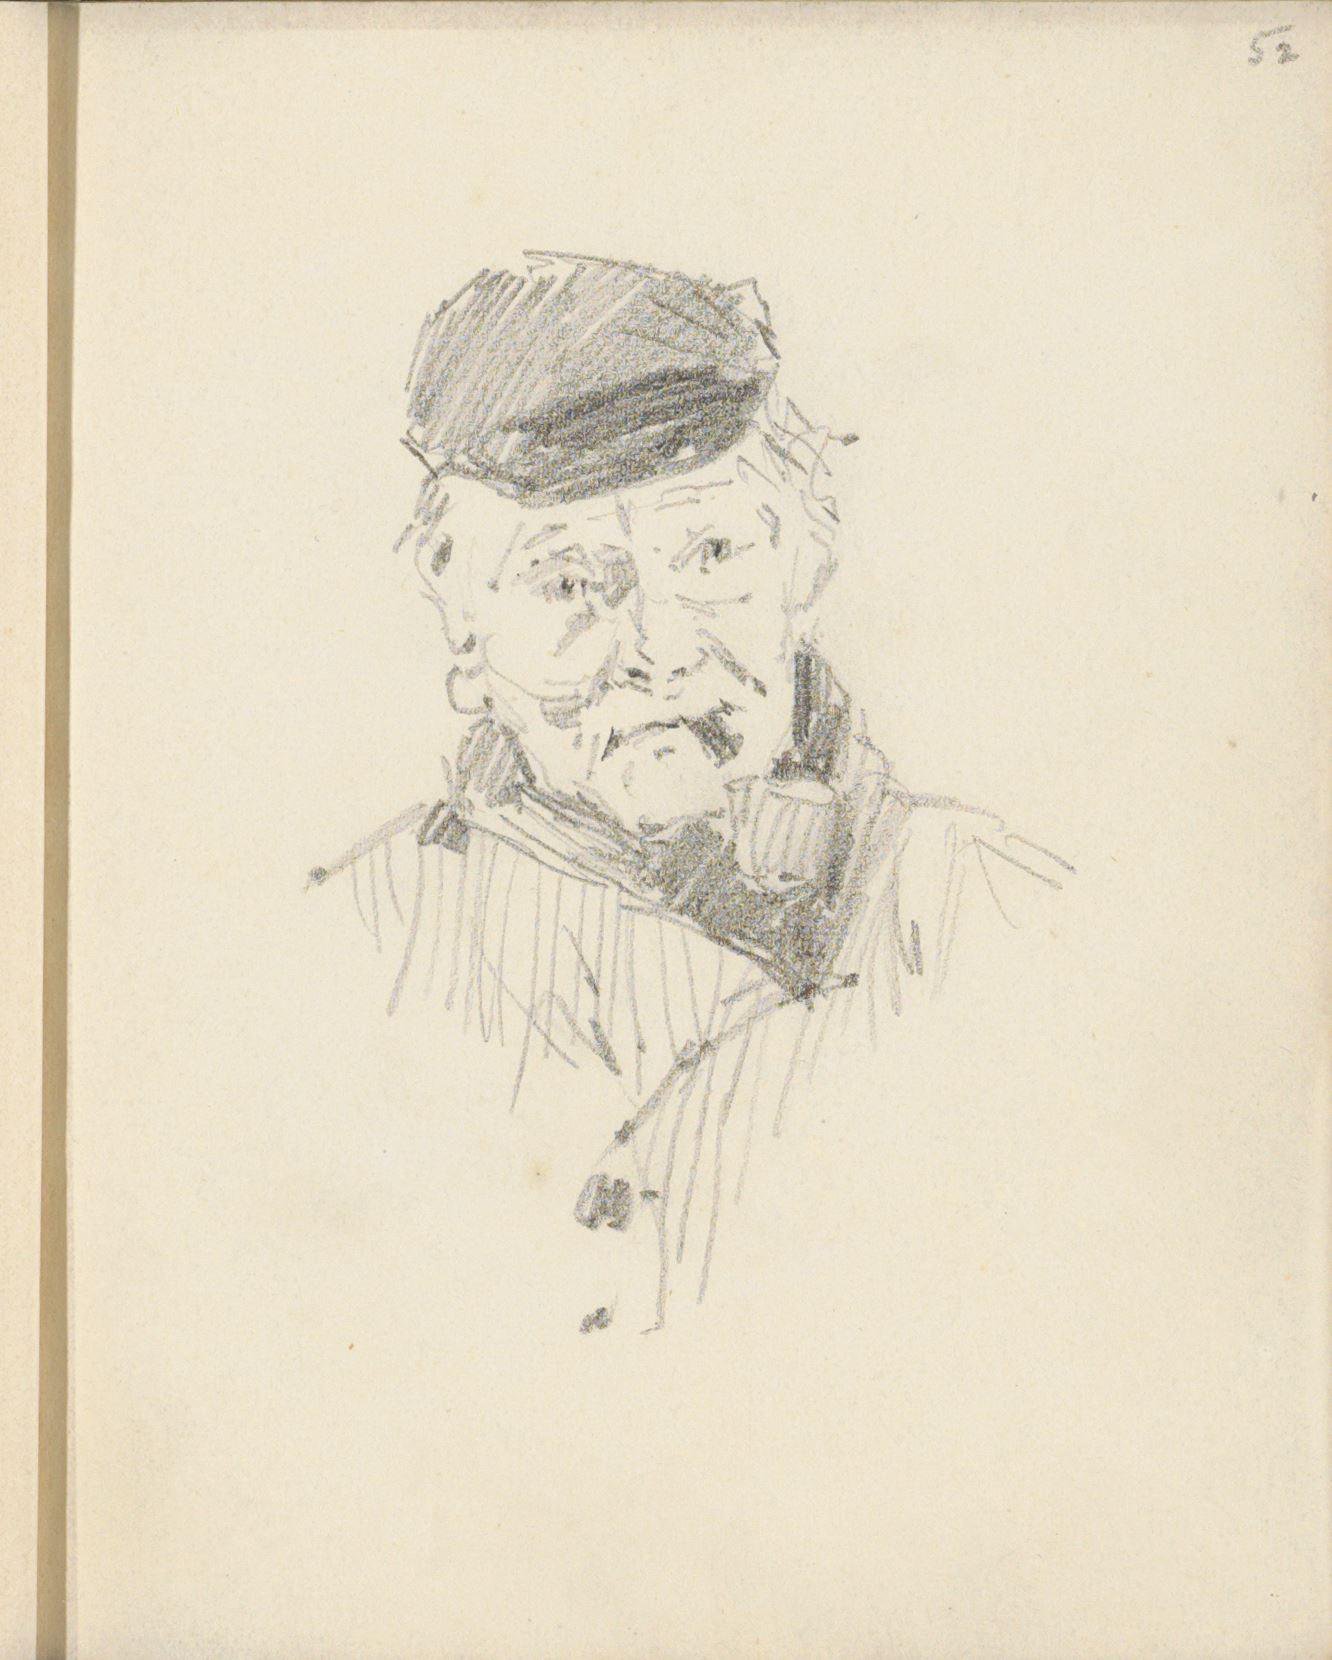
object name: sketchbook leaf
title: Pijprokende man met een pet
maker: alfred william rich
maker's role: draughtsman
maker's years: 1856-1921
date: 1892-1893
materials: paper, pencil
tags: pipe ~ tobacco, old man (+ front view)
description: Blad 52 recto uit een schetsboek met 86 bladen.